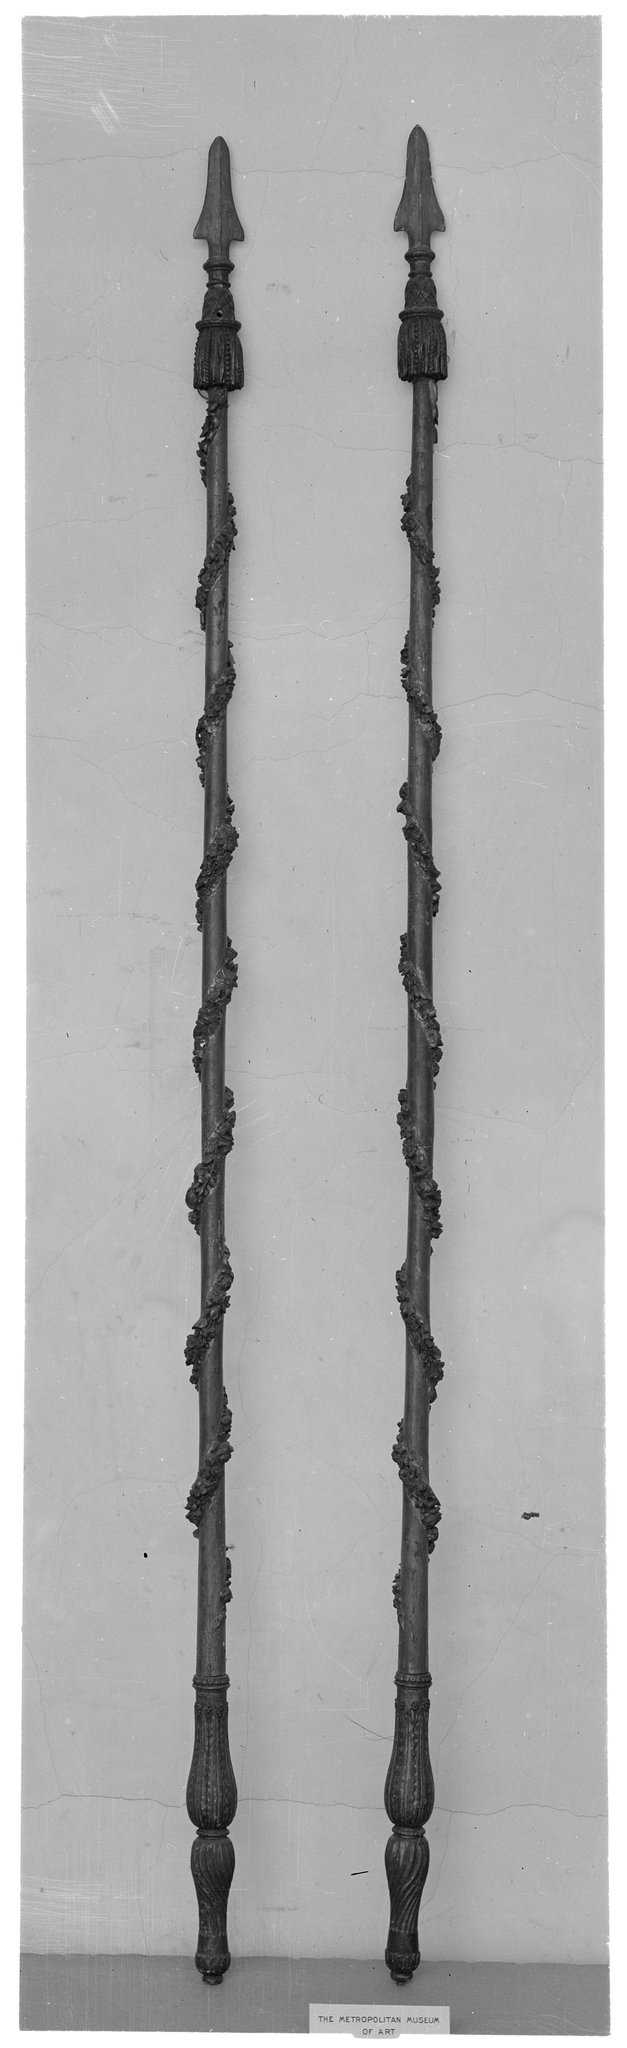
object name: spear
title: Pair of spears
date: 1701-1800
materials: wood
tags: spears